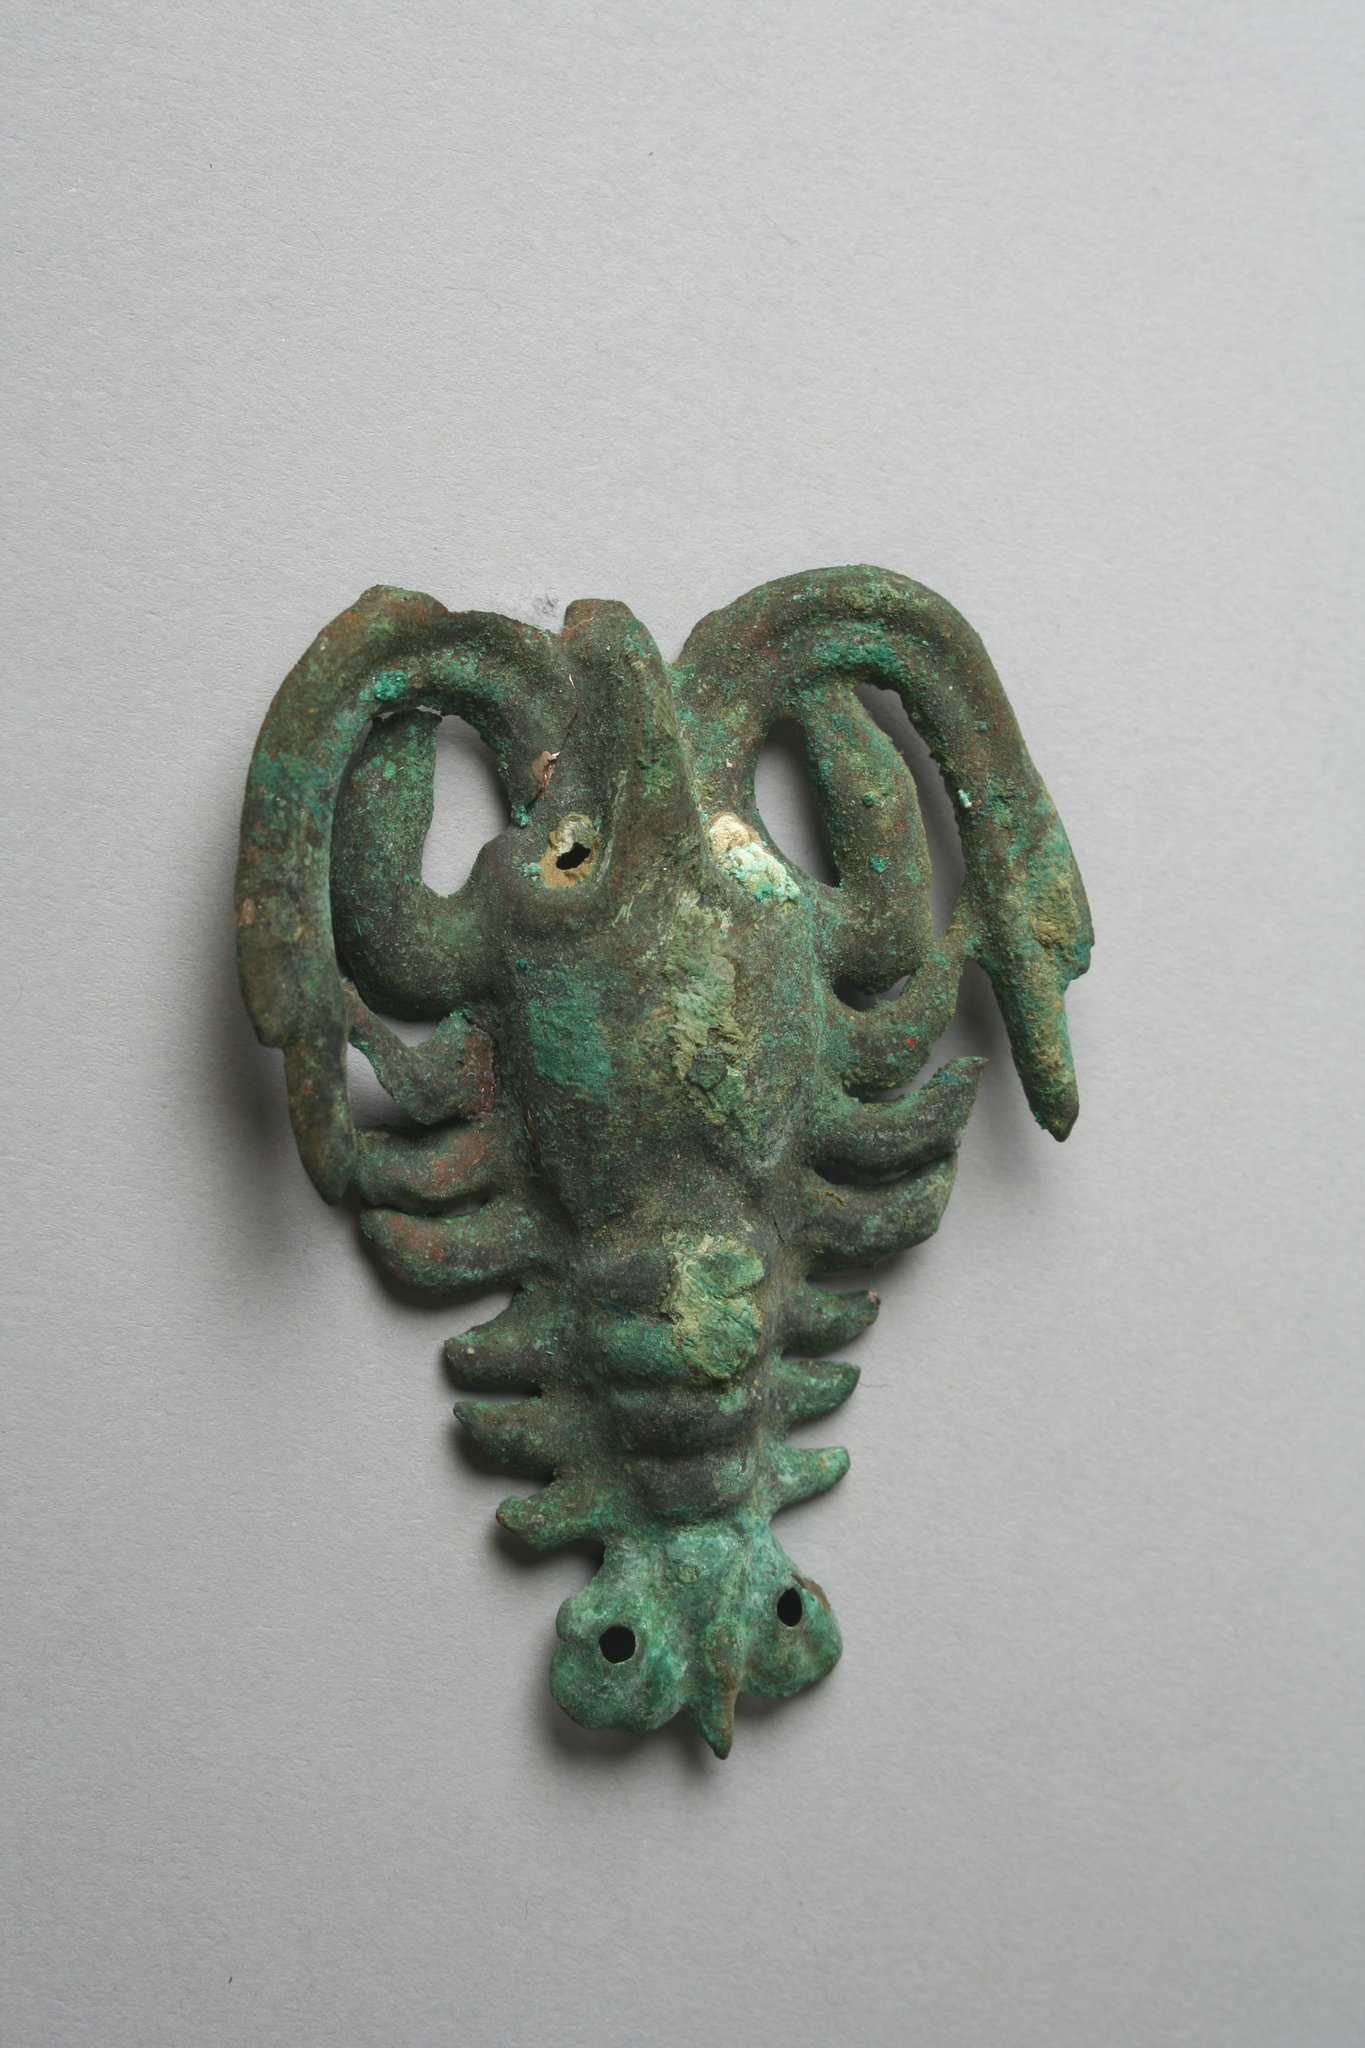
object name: ornament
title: Crayfish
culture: moche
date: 501-700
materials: gilt copper, shell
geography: peru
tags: crayfish